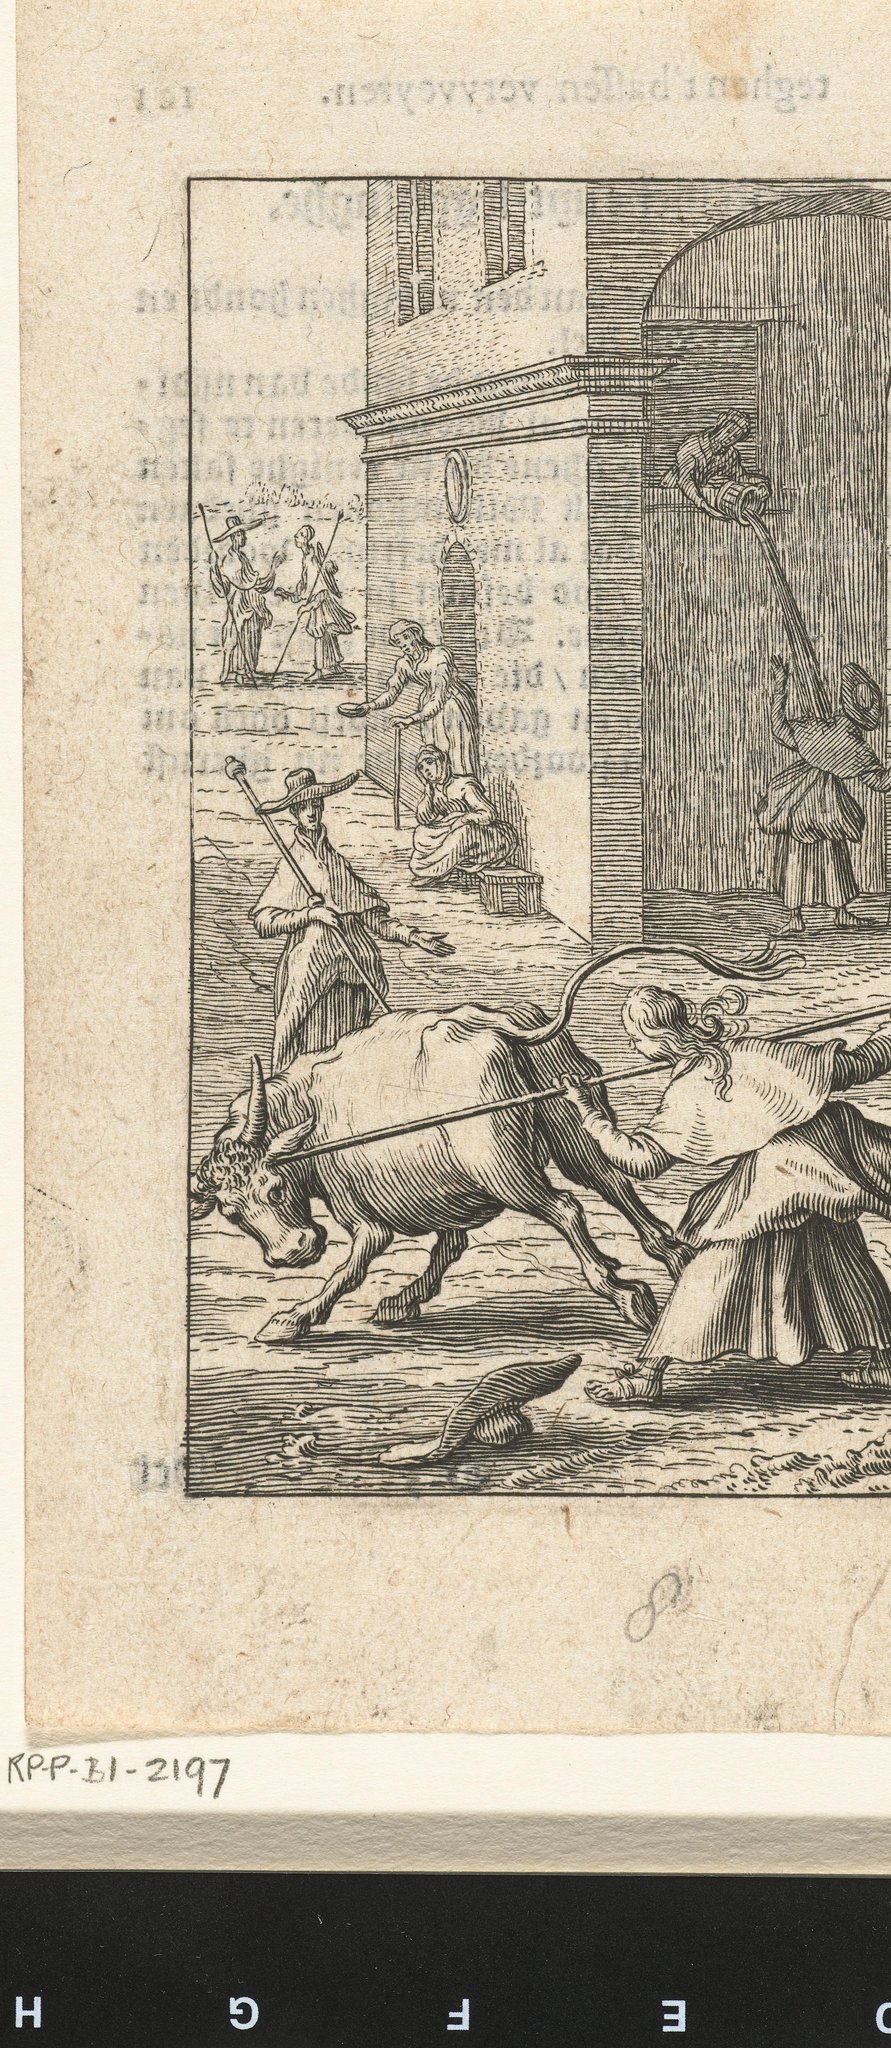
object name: print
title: Willemynken vecht met stier en Duyfken berispt haar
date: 1590-1627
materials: paper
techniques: engraving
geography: antwerp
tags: bull, pilgrim(s)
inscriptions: collector's mark: Lugt 2228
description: Prent uit: Boëtius Adamsz. Bolswert, Duyfkens en Willemynkens pelgrimagie tot haren beminden binnen Iervsalem. Haerlieder teghenspoet, belet en eynde, Antwerpen, Hendrick Aertssens, 1638. Op het verso staat een verklarende Nederlandse tekst bij de voorgaande illustratie in dit devotie boekje (vergelijk RP-P-BI-2196).